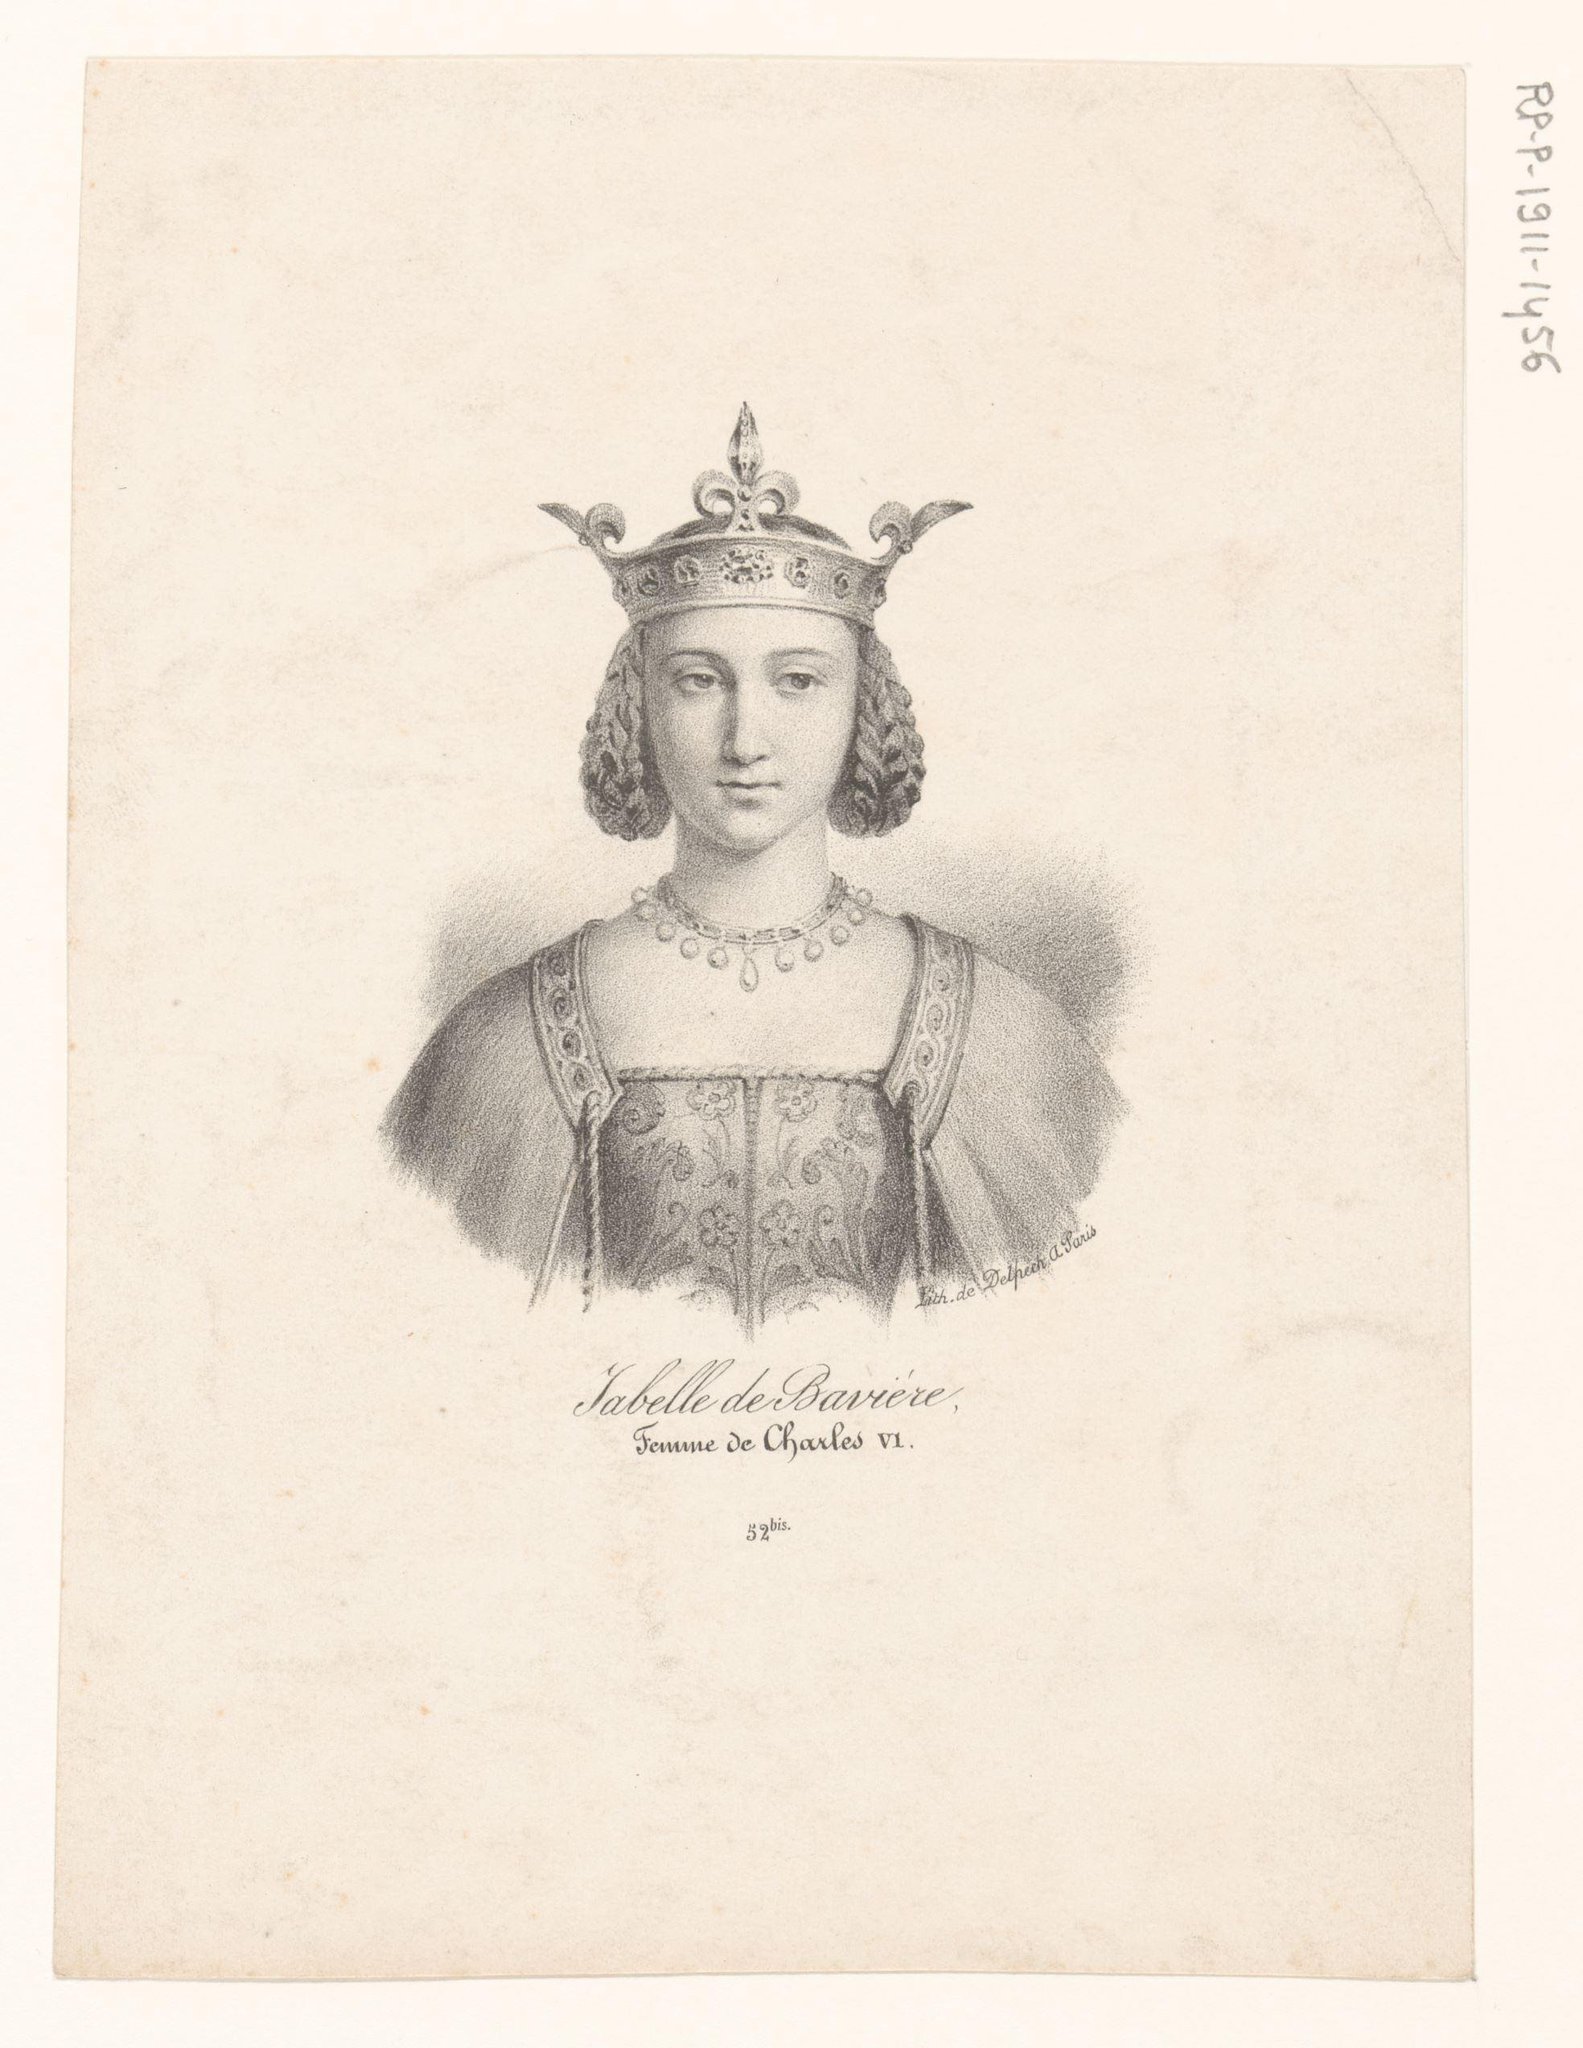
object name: print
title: Portret van Isabella van Beieren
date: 1818-1842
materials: paper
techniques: lithograph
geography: paris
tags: paris, historical persons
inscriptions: collector's mark: Lugt 2228a